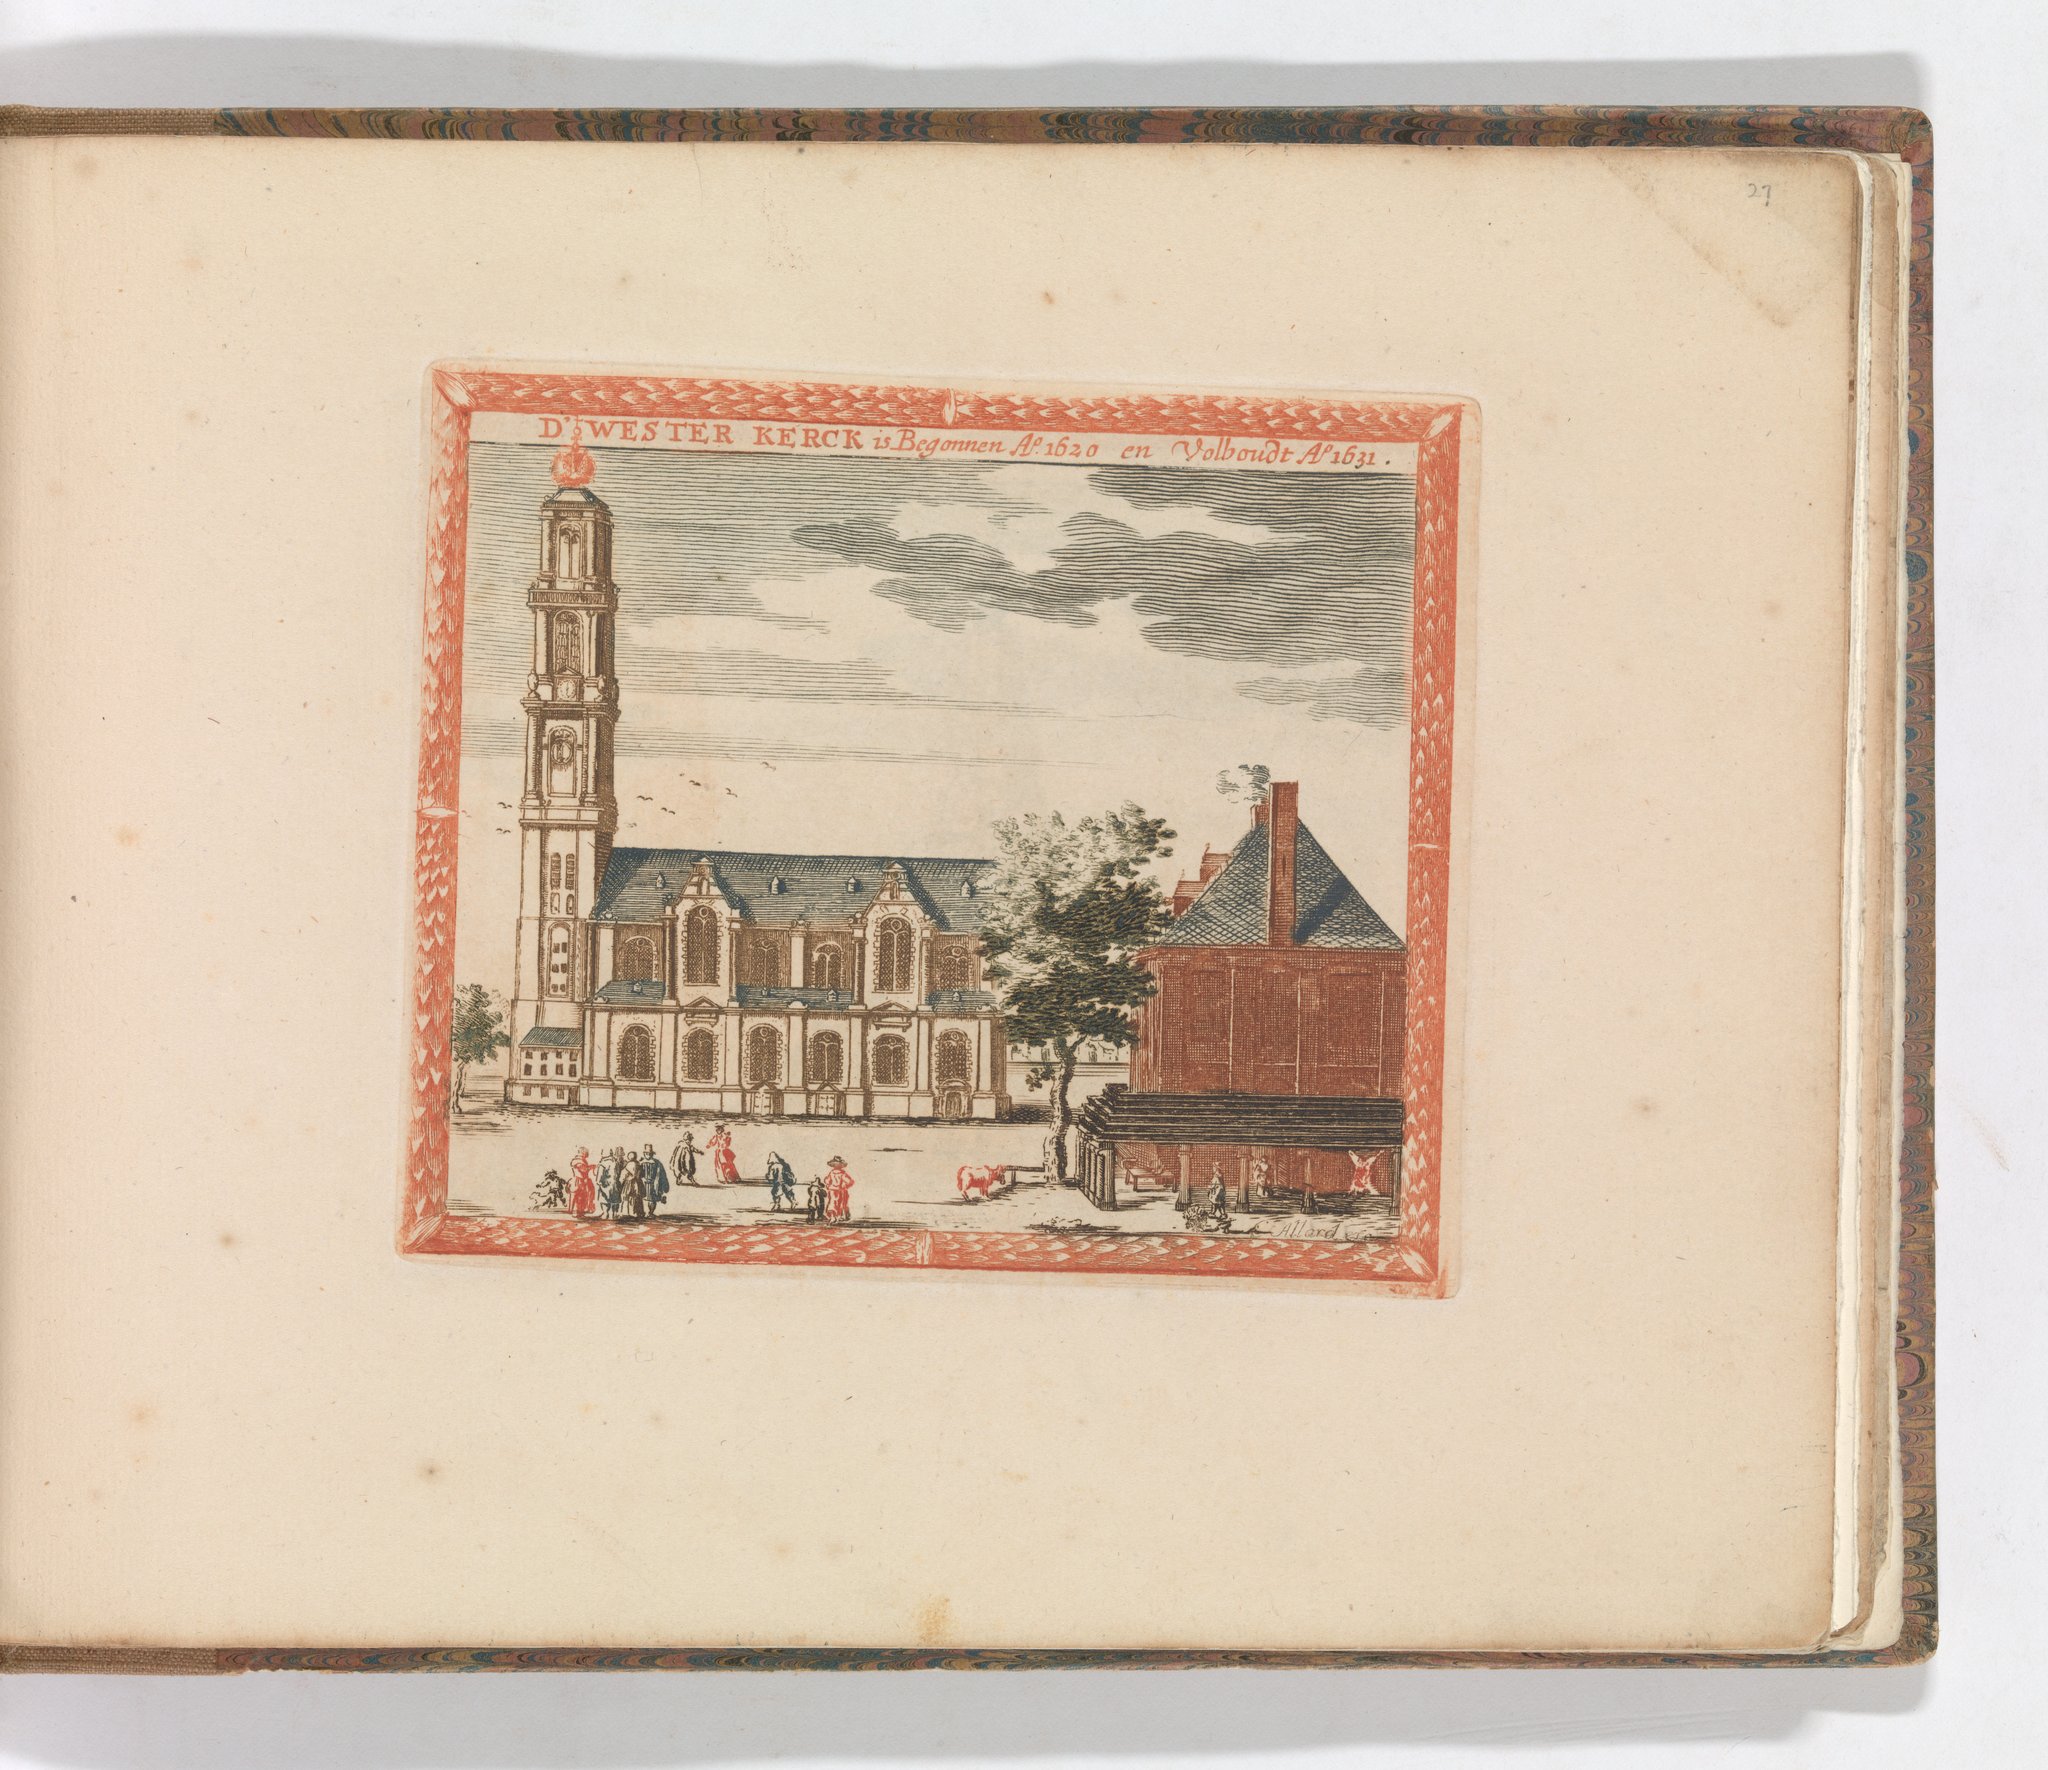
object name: book print ornament architecture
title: 'D' Wester Kerck', in: Tooneel Der Voornaamste Nederlands Huizen, En Lust Hoven, Naar T Leven Afgebeeld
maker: carel allard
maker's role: publisher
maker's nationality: dutch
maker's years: 1648-1709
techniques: engraving, lithography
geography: amsterdam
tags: houses,towers